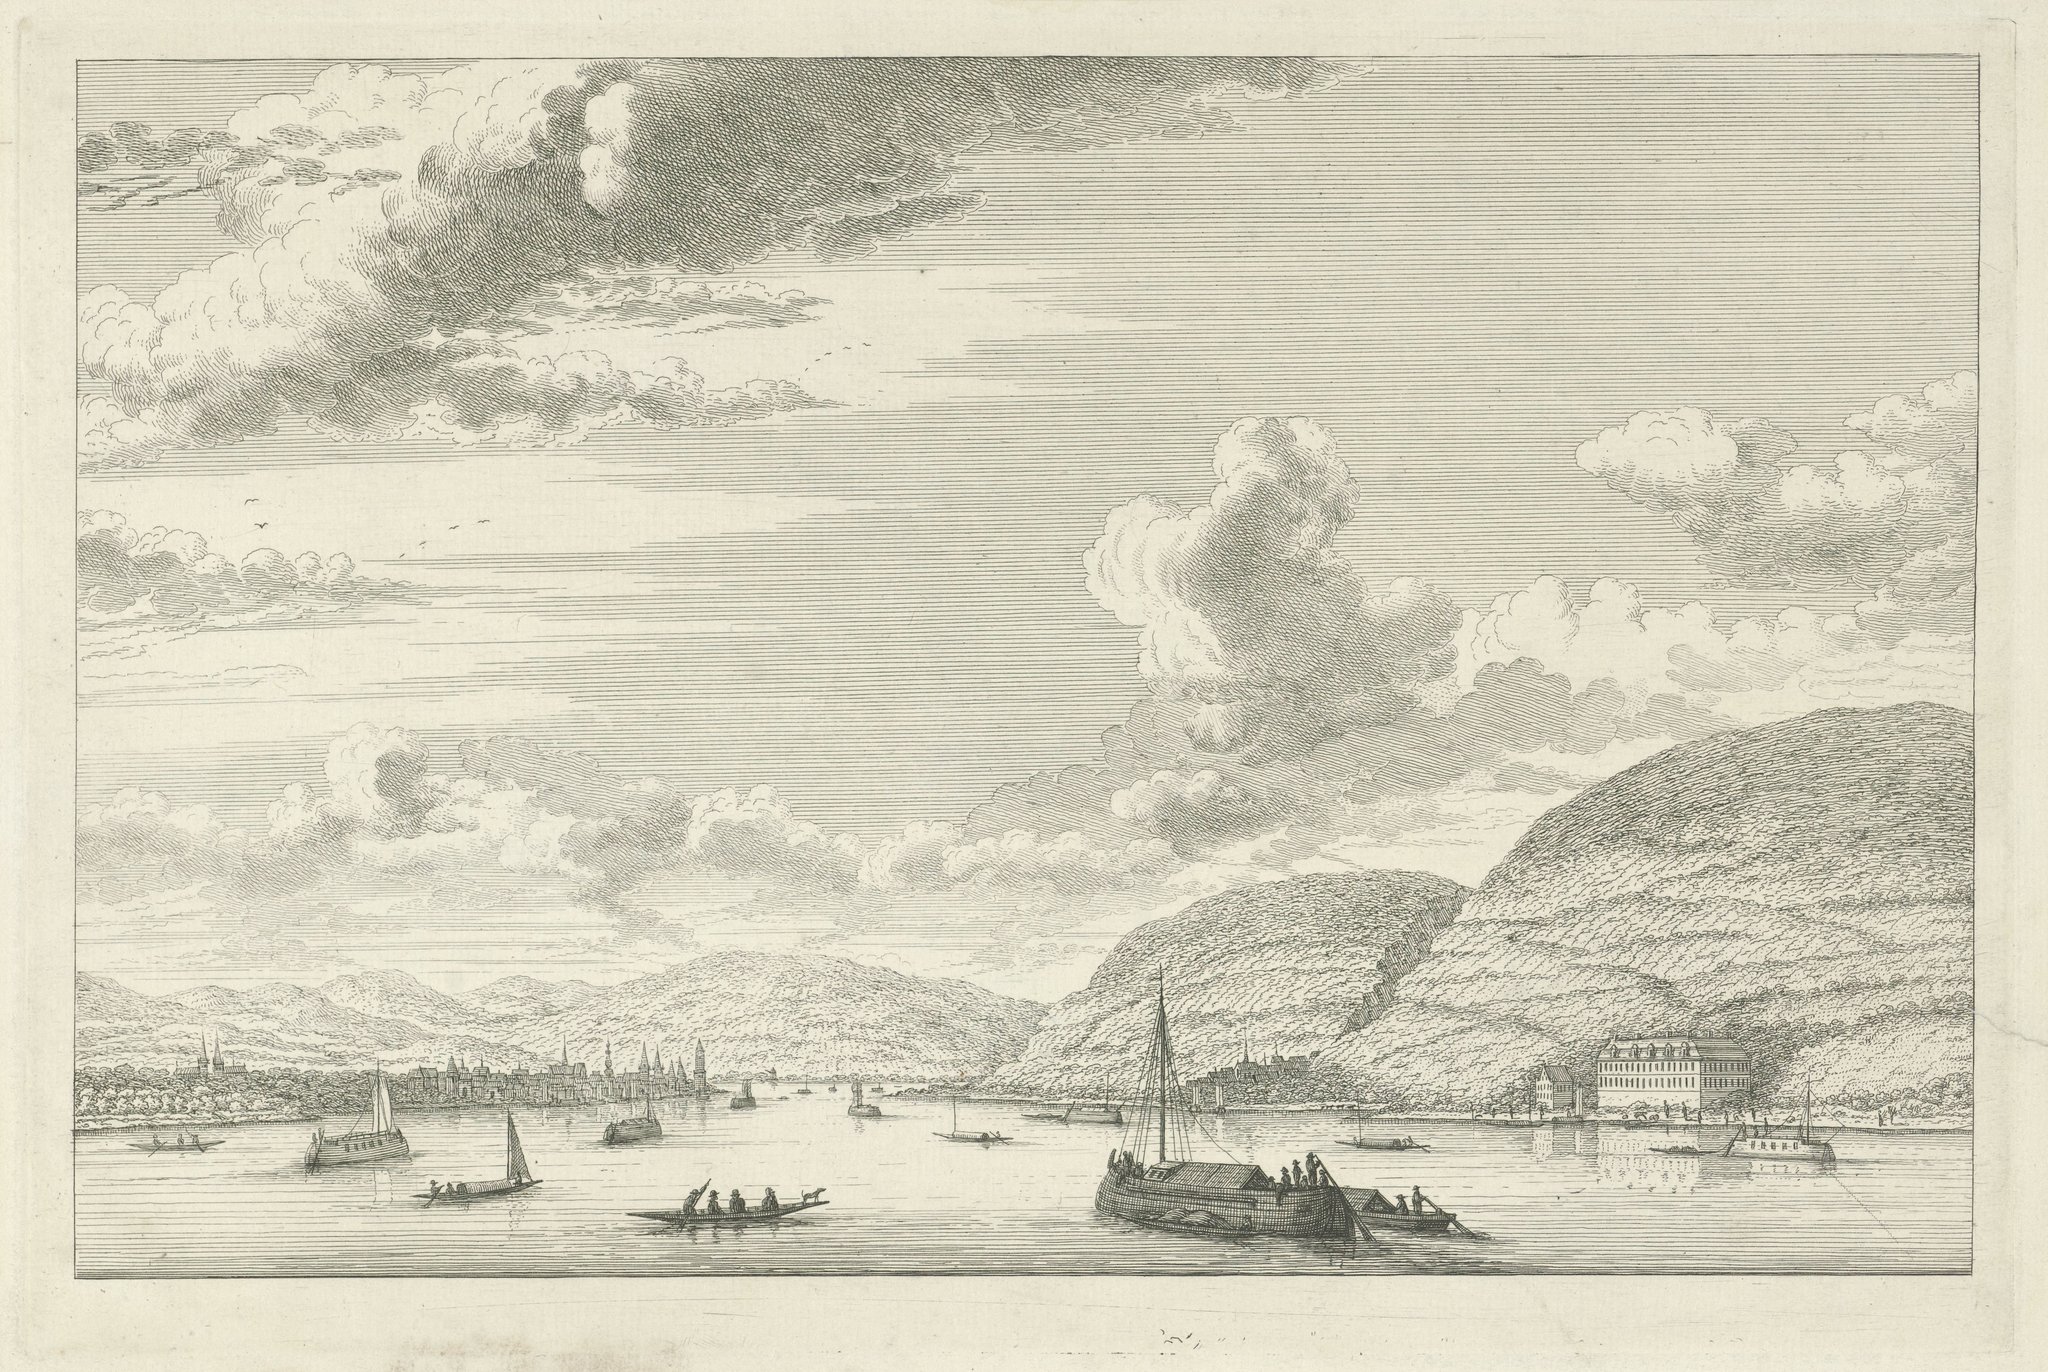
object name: print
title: Gezichten langs den Rhyn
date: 1767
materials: paper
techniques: etching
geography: amsterdam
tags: river, ships (in general), prospect of city, town panorama, silhouette of city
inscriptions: collector's mark: Lugt 2228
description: Gezicht op de Rijn nabij een stad. Rechts ligt een groot buitenhuis aan de oever. De prent maakt deel uit van een elfdelige serie prenten met gezichten langs de Rijn.